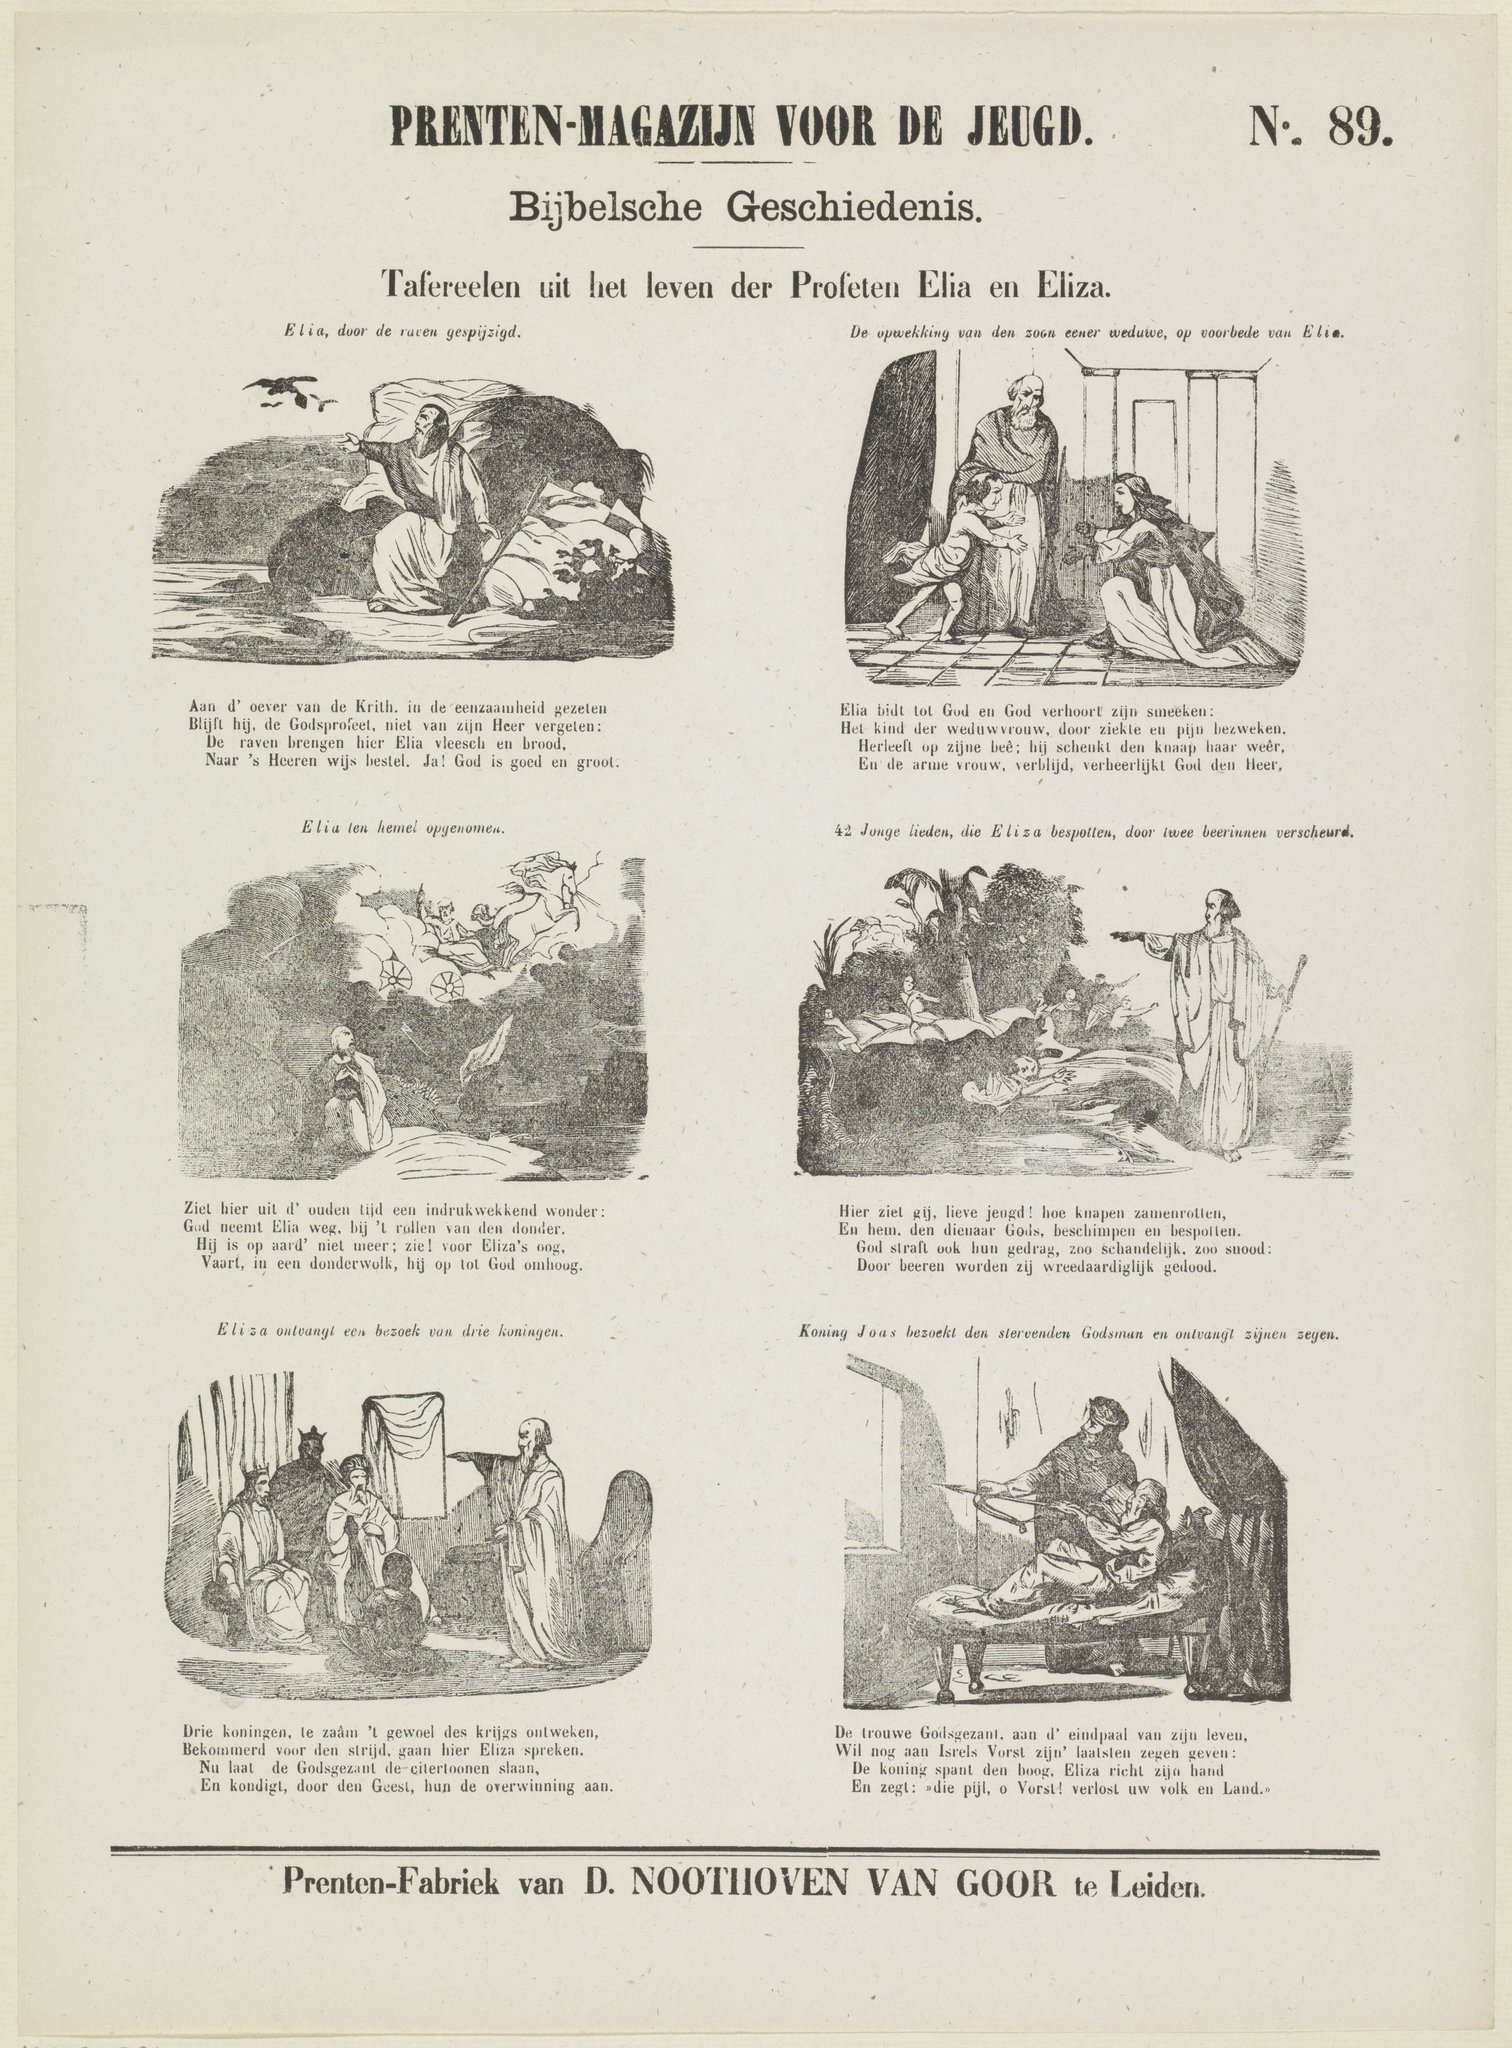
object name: print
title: Tafereelen uit het leven der profeten Elia en Eliza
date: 1850-1881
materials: paper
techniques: letterpress printing, engraving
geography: leiden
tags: story of elisha (eliseus), story of elijah (elias), old testament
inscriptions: collector's mark: Lugt 2760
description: Blad met 6 voorstellingen uit het leven van de oudtestamentische profeten Elia en Elisa. Boven elke voorstelling een titel en onder elke voorstelling een vierregelig vers. Genummerd rechtsboven: No. 89.